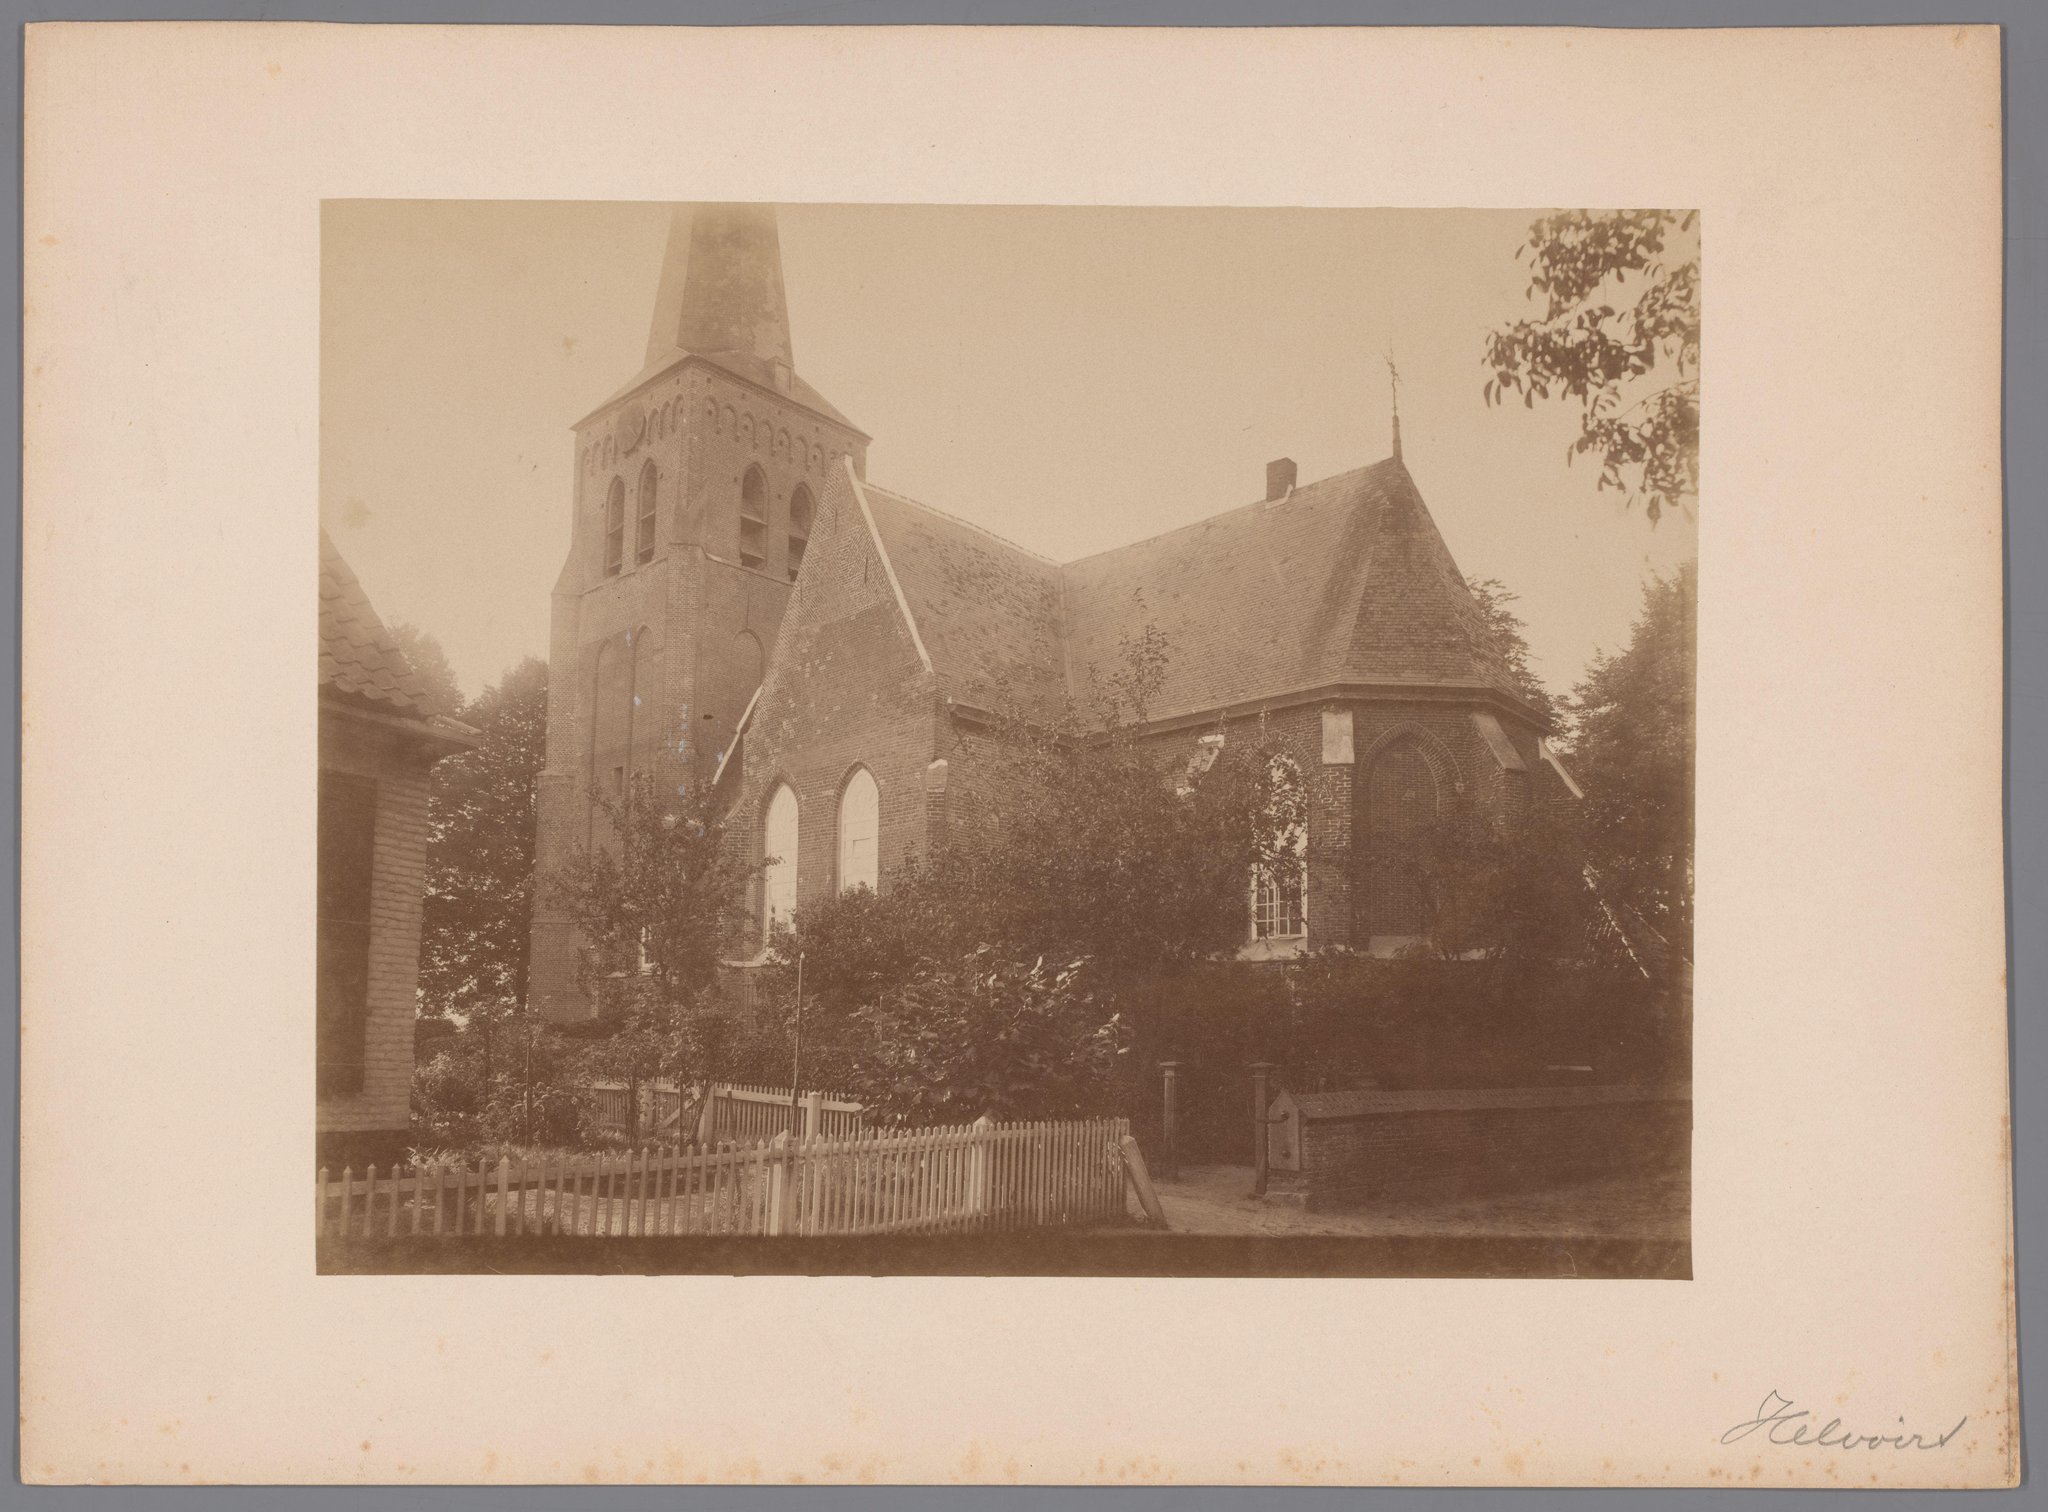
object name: photograph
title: Zuidoostzijde van de oude Sint-Nicolaaskerk te Helvoirt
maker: anoniem (monumentenzorg)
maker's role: fotograaf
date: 1895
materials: cardboard, photographic support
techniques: albumen print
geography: helvoirt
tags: church (exterior)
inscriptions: annotation: ‘Helvoirt’, annotation: ‘Helvoort (N.B.)/ Z.O. zijde v/d N.H. Kerk/ sept 1895’